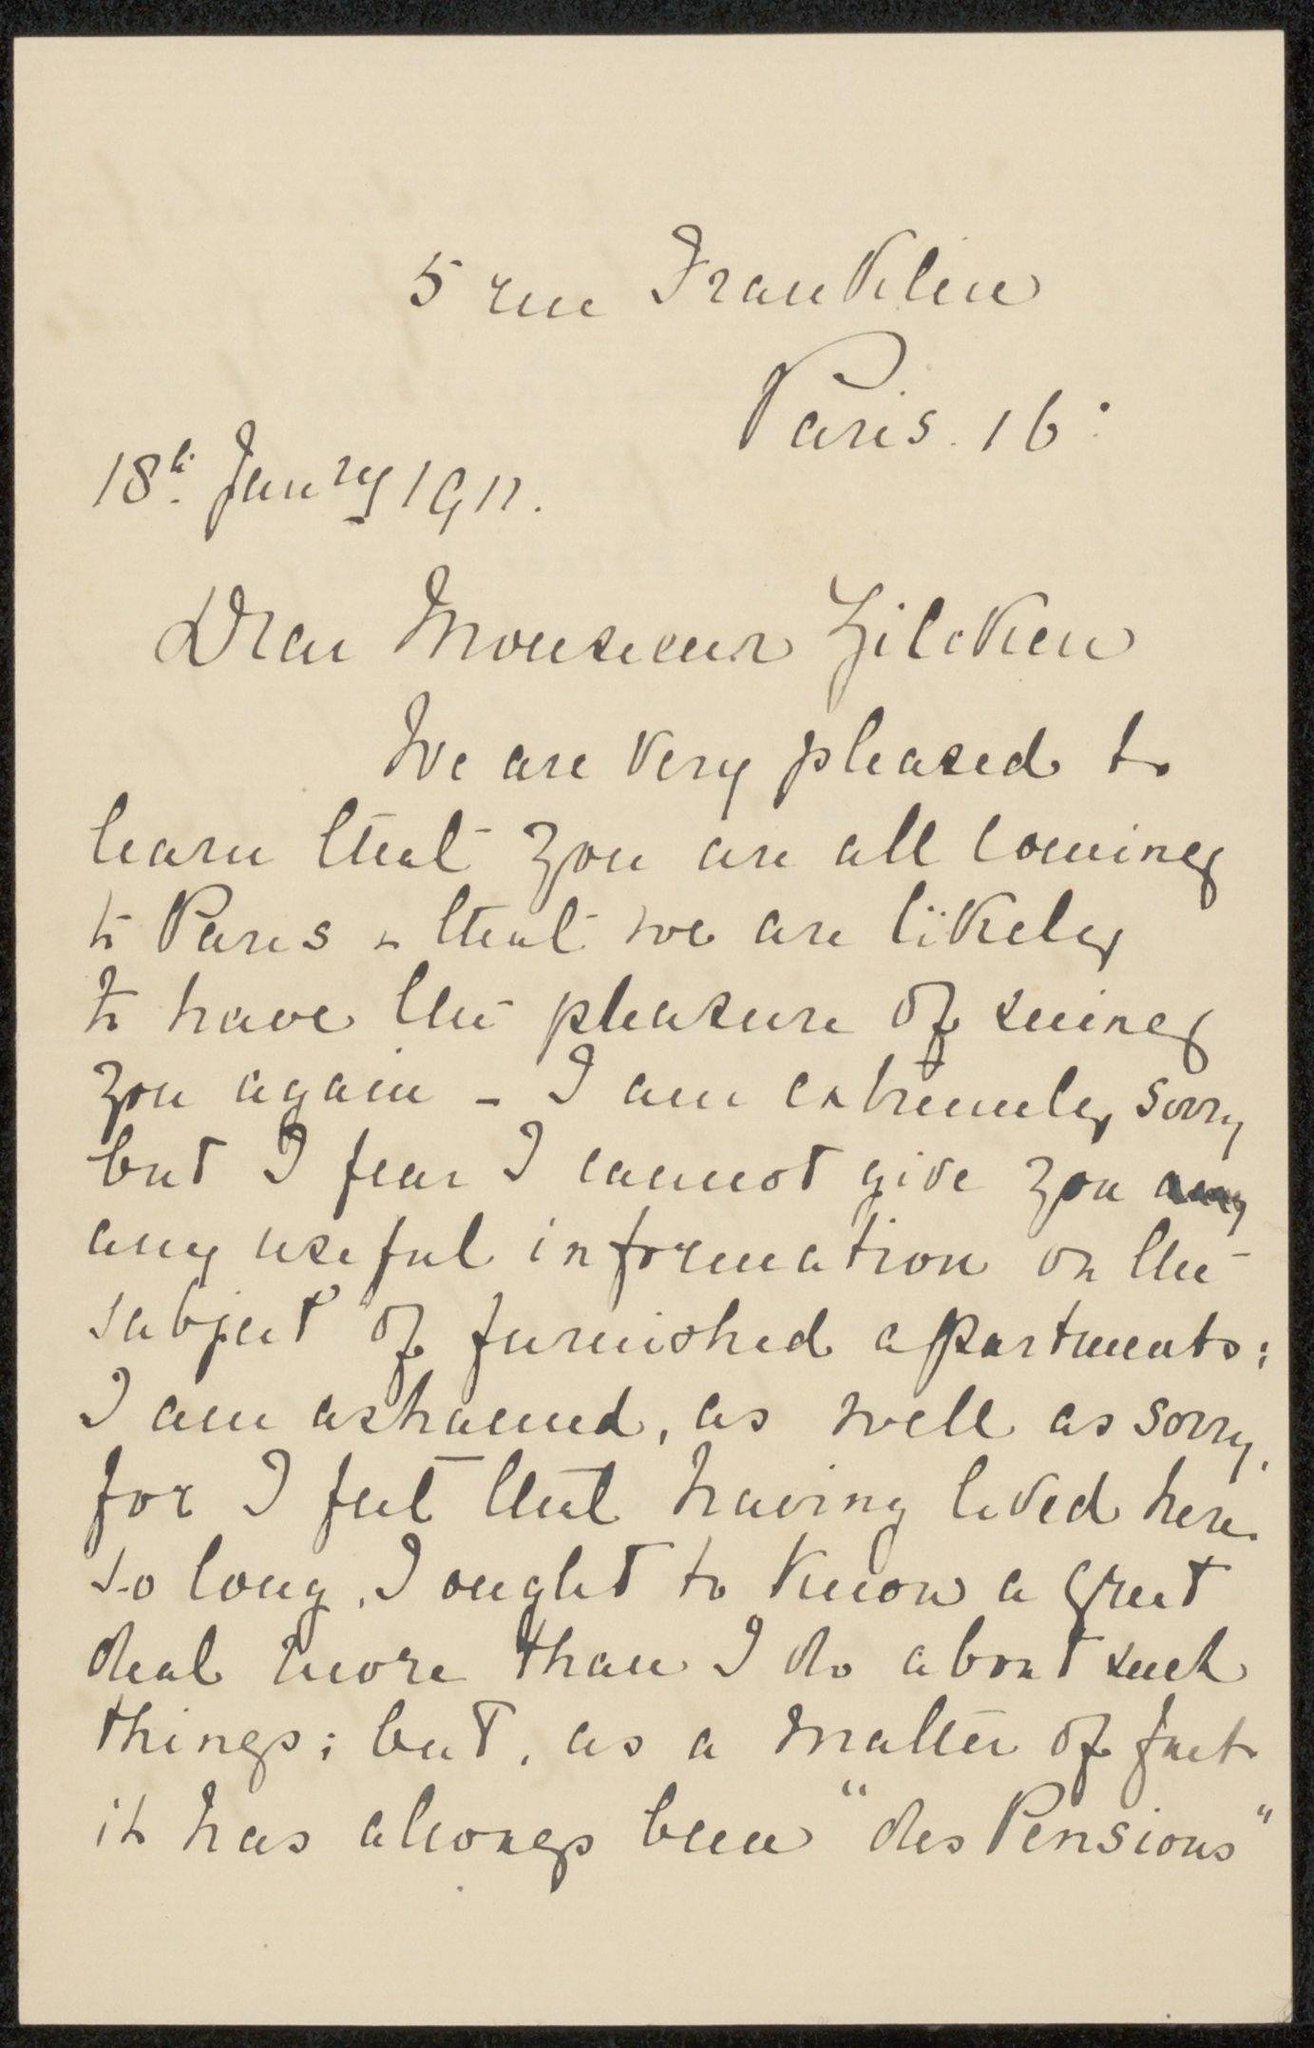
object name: letter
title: Brief aan Philip Zilcken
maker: henrietta buhot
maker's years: -1913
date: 1911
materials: ink, paper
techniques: pen, writing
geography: paris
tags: painter, draughtsman, philip zilcken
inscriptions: collector's mark: ‘RPK’, watermark: ‘LESCALIER’